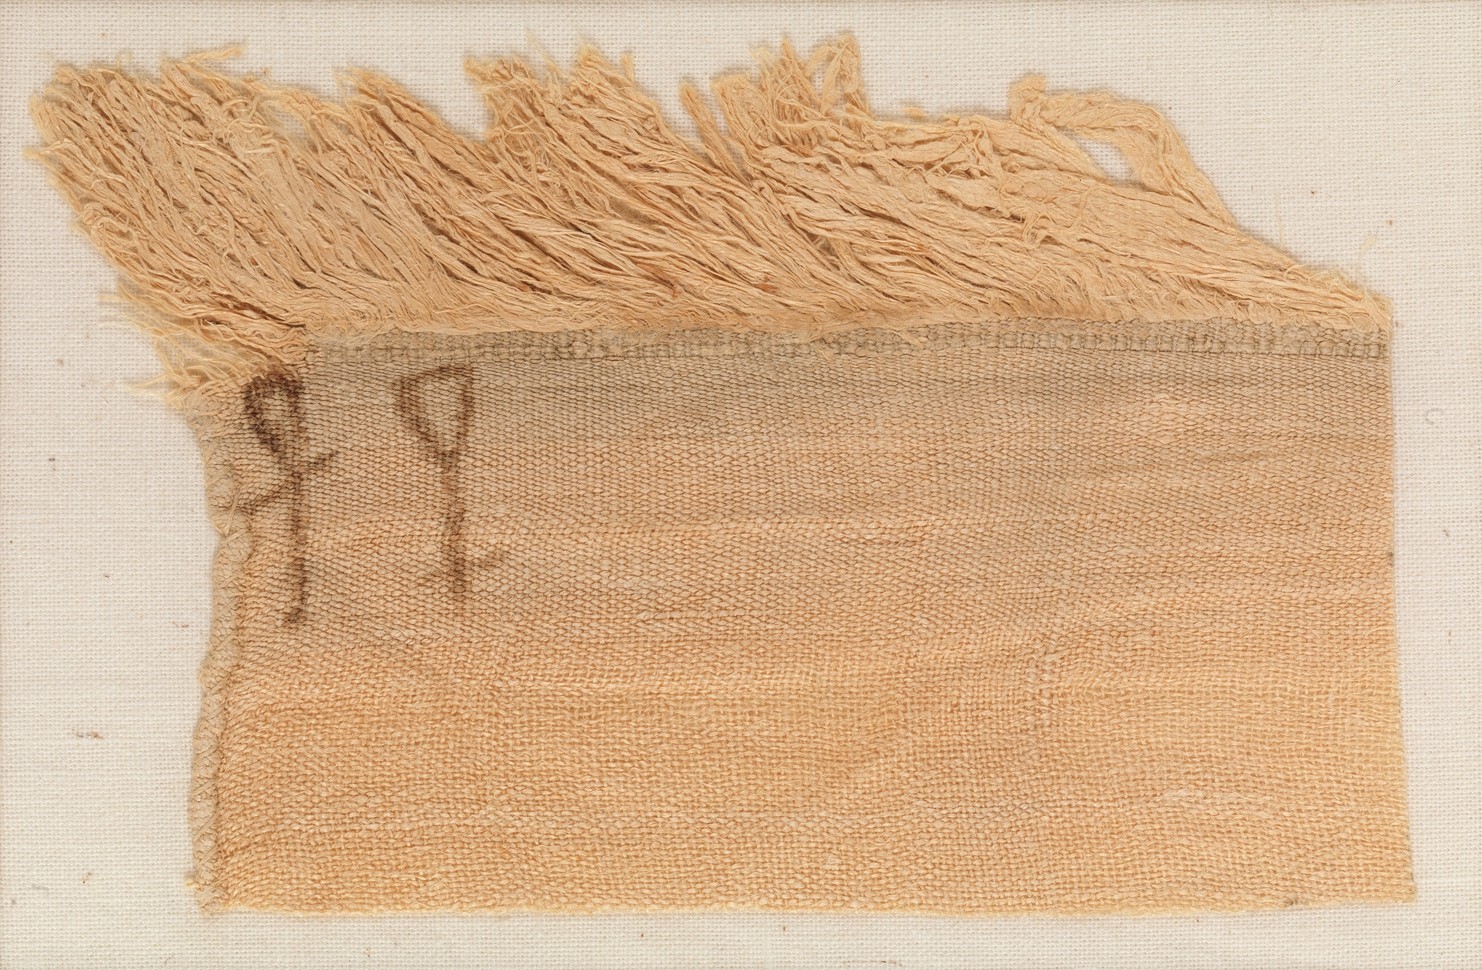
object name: linen mark, wah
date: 1981-1975 BCE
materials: linen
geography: egypt